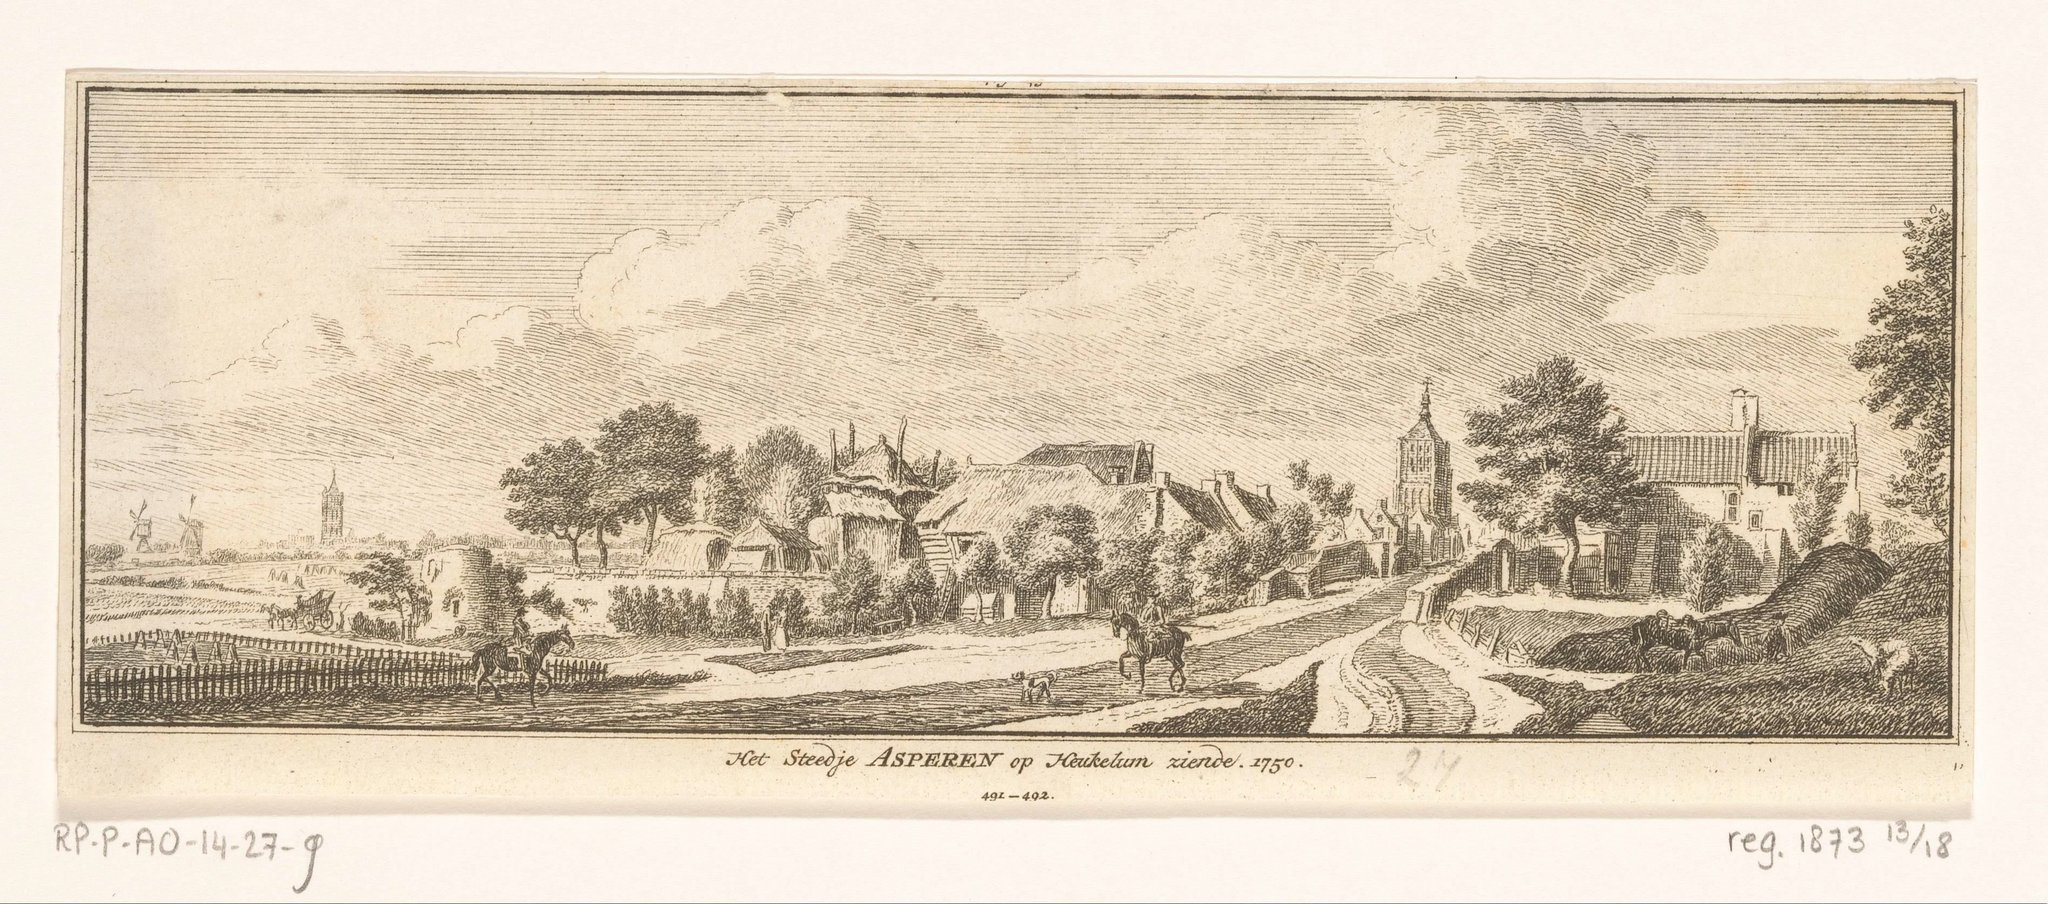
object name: book illustration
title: Gezicht op Asperen, 1750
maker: hendrik spilman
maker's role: draughtsman, painter, print maker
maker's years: 1721-1784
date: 1757-1792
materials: paper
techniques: etching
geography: haarlem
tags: church (exterior), prospect of city, town panorama, silhouette of city, asperen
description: Oorspronkelijk van één plaat gedrukt met 'Het steedje Heukelum langs de Linge te zien. 1750'. Hele prent ook gebruikt in: Het verheerlykt Nederland of kabinet van hedendaagsche gezigten van steden, dorpen (…). 9 delen. Amsterdam: Isaak Tirion en weduwe Isaak Tirion, 1745-1774, dl. 6 (1757), ill. 489-490. Of in: Nederlandsche tafereelen; of eene keurige verzameling van negen honderd fraaije gezigten van steden, dorpen, sloten, oudheden (….). 9 delen. Amsterdam: Jan de Groot, 1792, dl. 6, ill. 489-490.